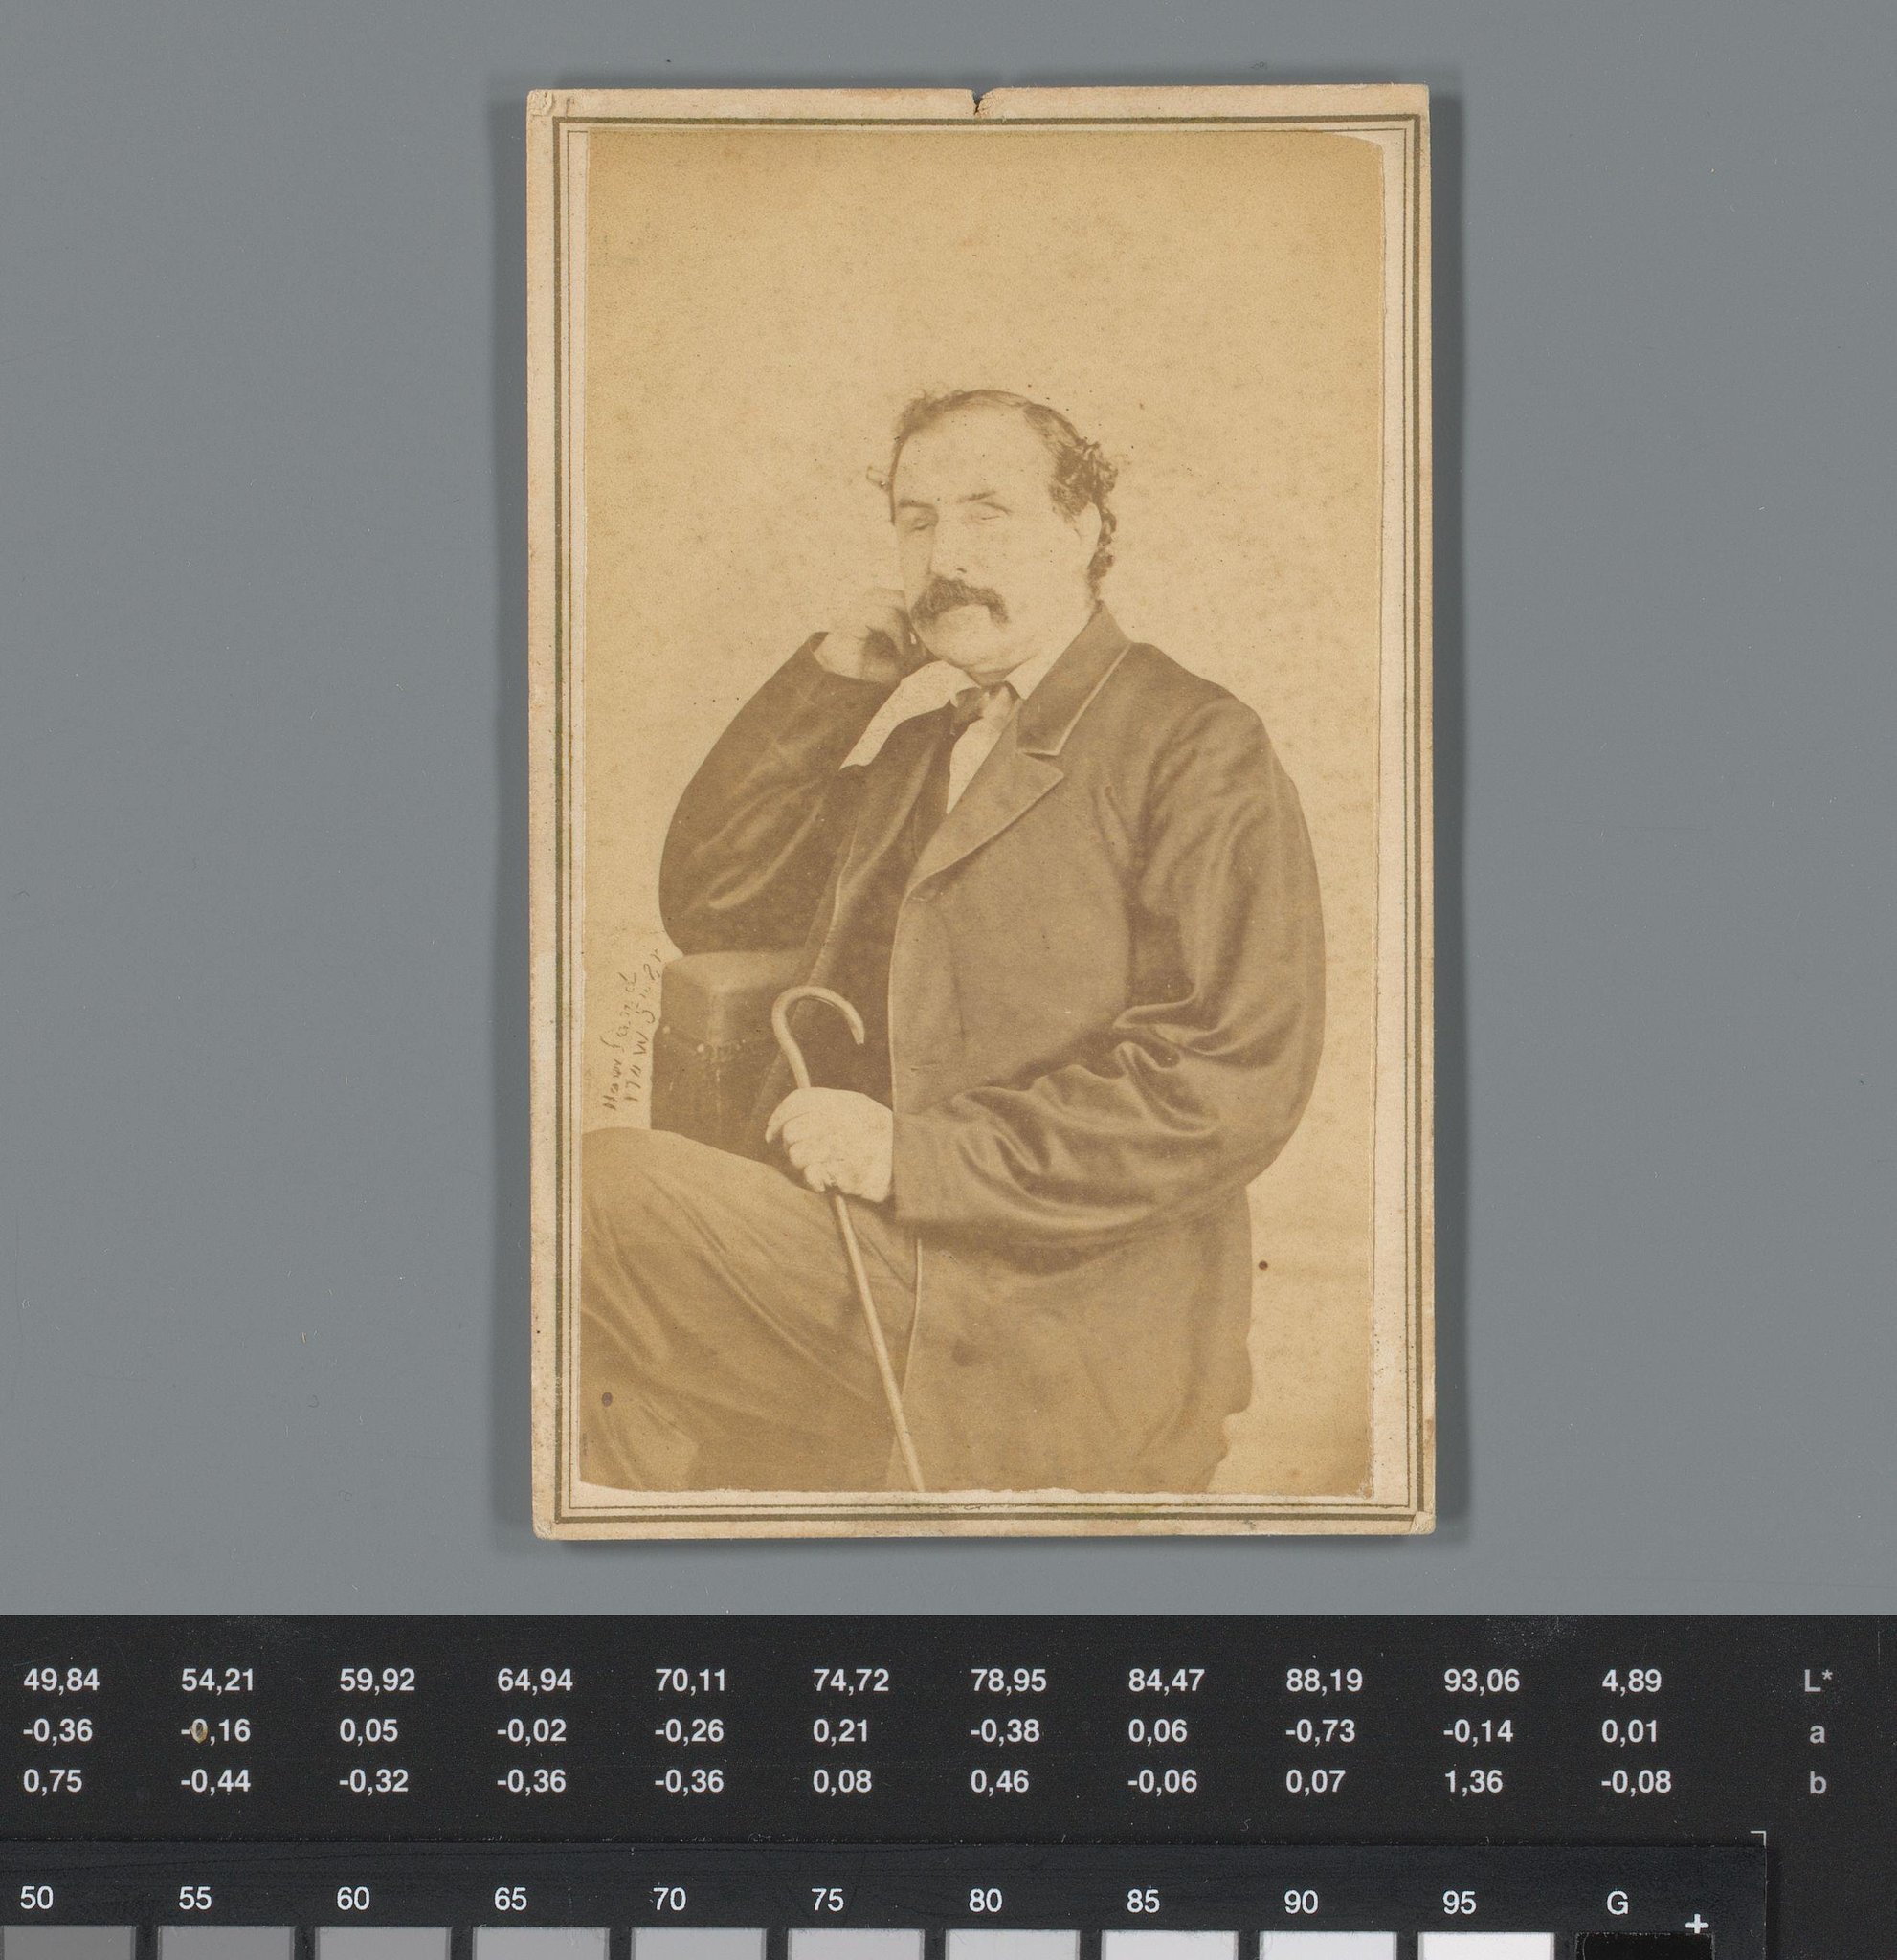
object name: carte de visite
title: Reclame voor geschenken van L.D. Sine te Cincinnati, met portret van L.D. Sine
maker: Anonymous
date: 1850-1915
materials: cardboard, photographic support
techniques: albumen print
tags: advertising, historical persons, blind, blindness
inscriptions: inscription: ‘L. D. SINE. / The above named gentleman is well known as the pioneer of Gift Enterprises. (...) Cincinnati, Ohio.’